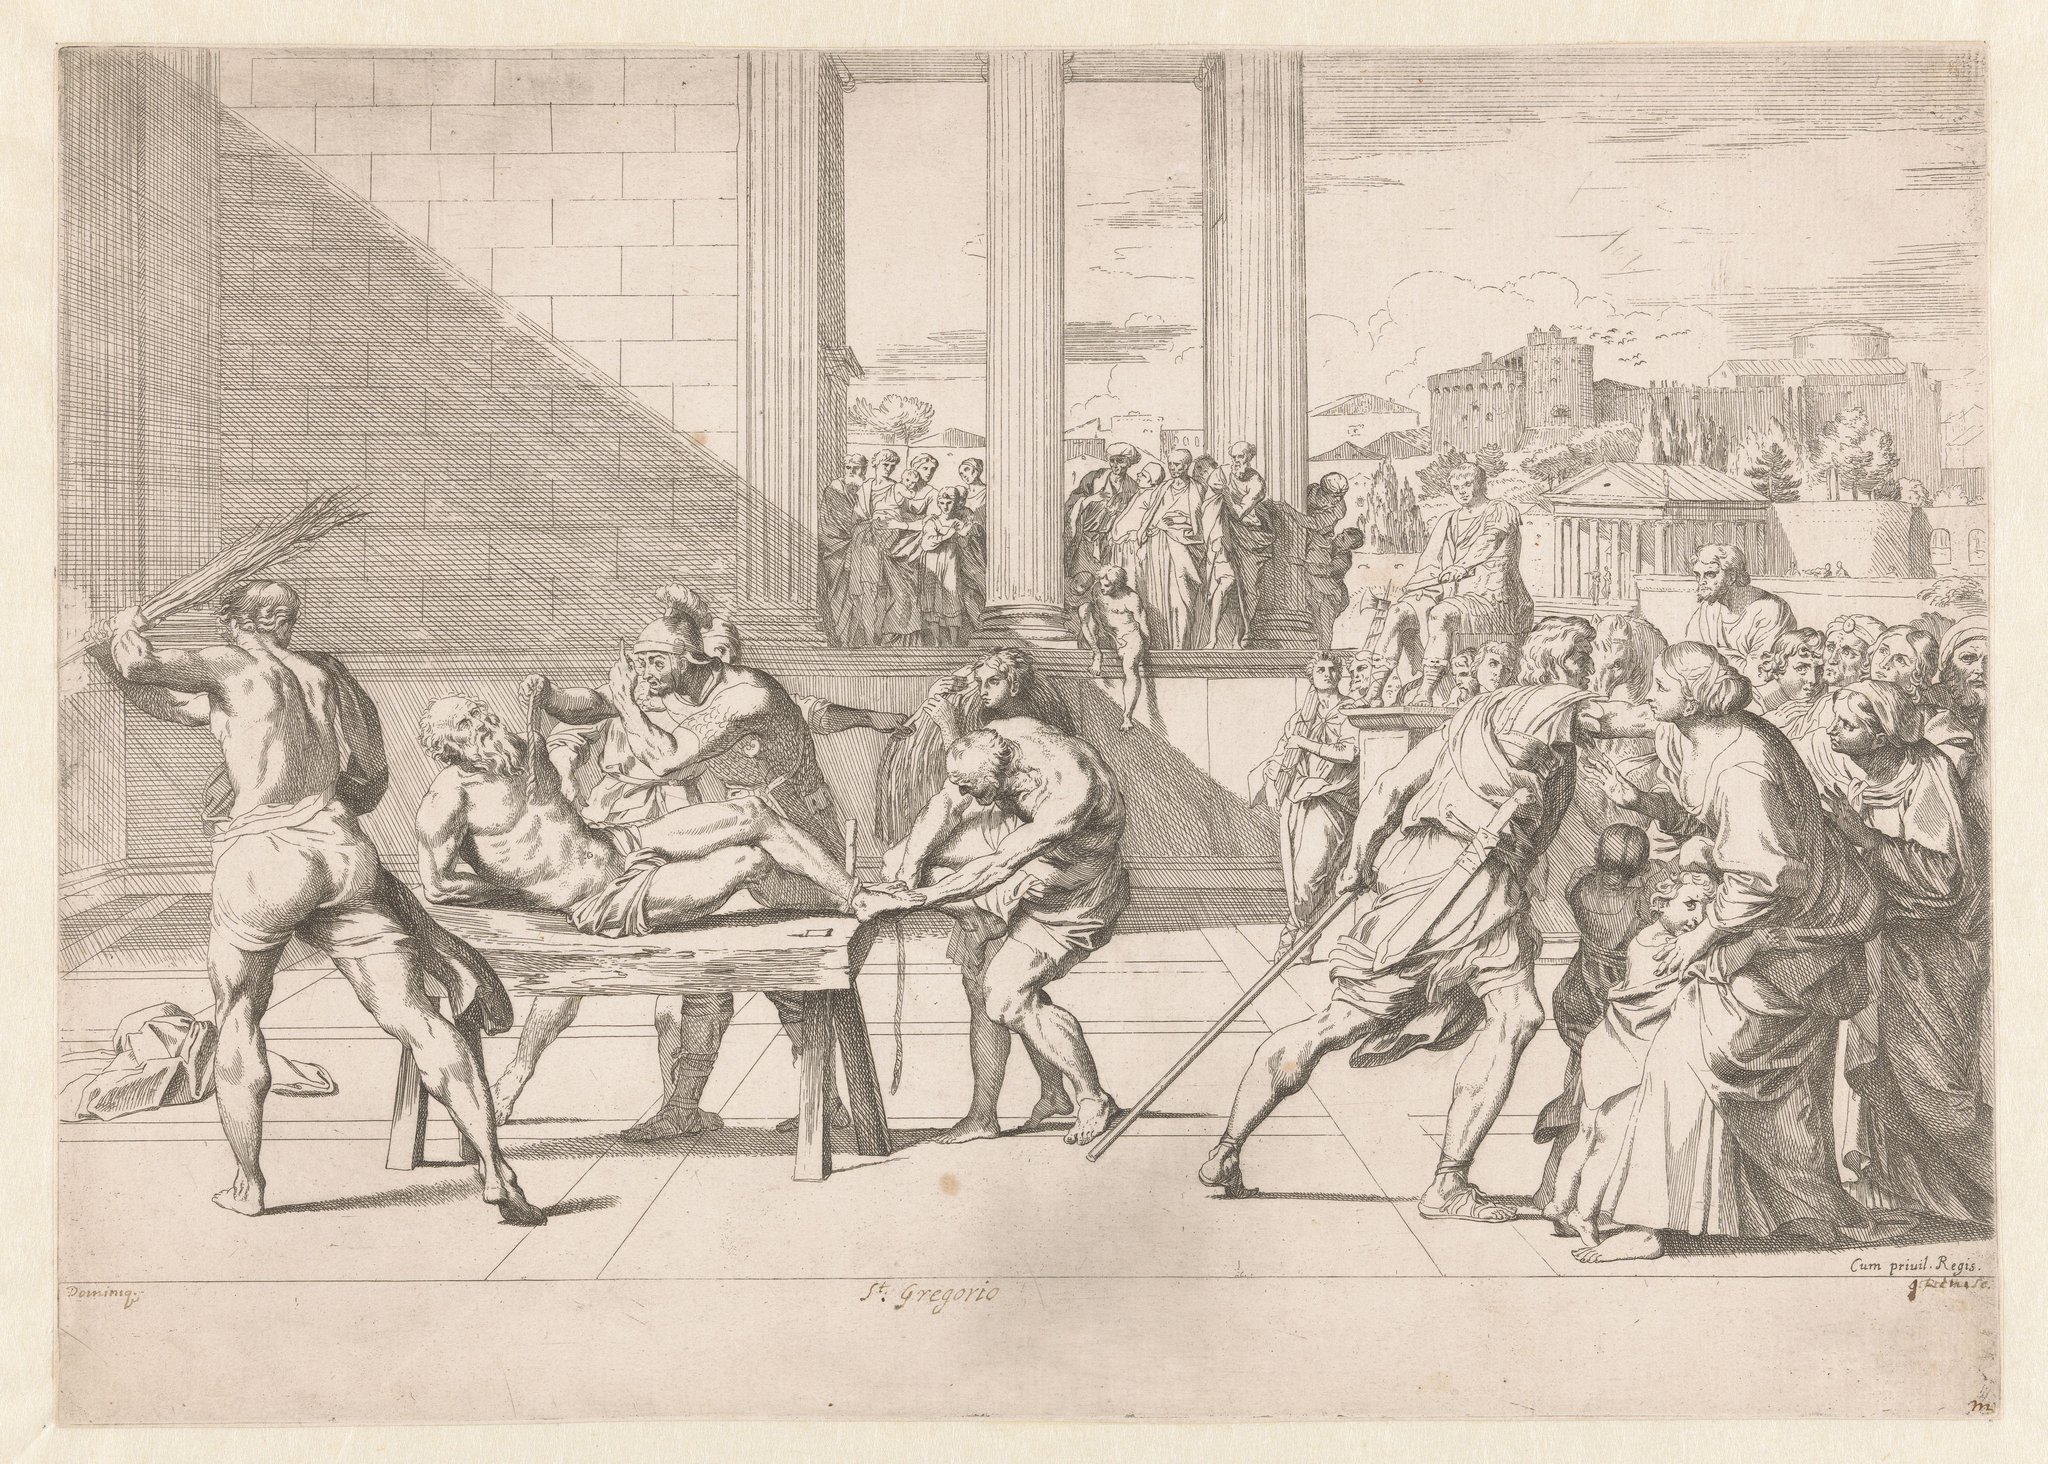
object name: print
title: Martelaarschap van de heilige Andreas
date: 1635-1713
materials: paper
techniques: etching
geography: rome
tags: martyrdom and death of andrew, the apostle andrew; possible attributes: book, x-shaped cross, fish, fishing-net, rope, scroll - martyrdom, suffering, misfortune, death of male saint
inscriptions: inscription: ‘St. Gregorio’, inscription: ‘Dominiq.’, collector's mark: Lugt 240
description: Zicht in een ruimte waar de heilige Andreas vastgebonden ligt op een houten tafel. Hij wordt door verschillende mannen gemarteld. Een menigte kijkt toe. Rechts een doorkijk naar een landschap met een tempel en andere bouwwerken.